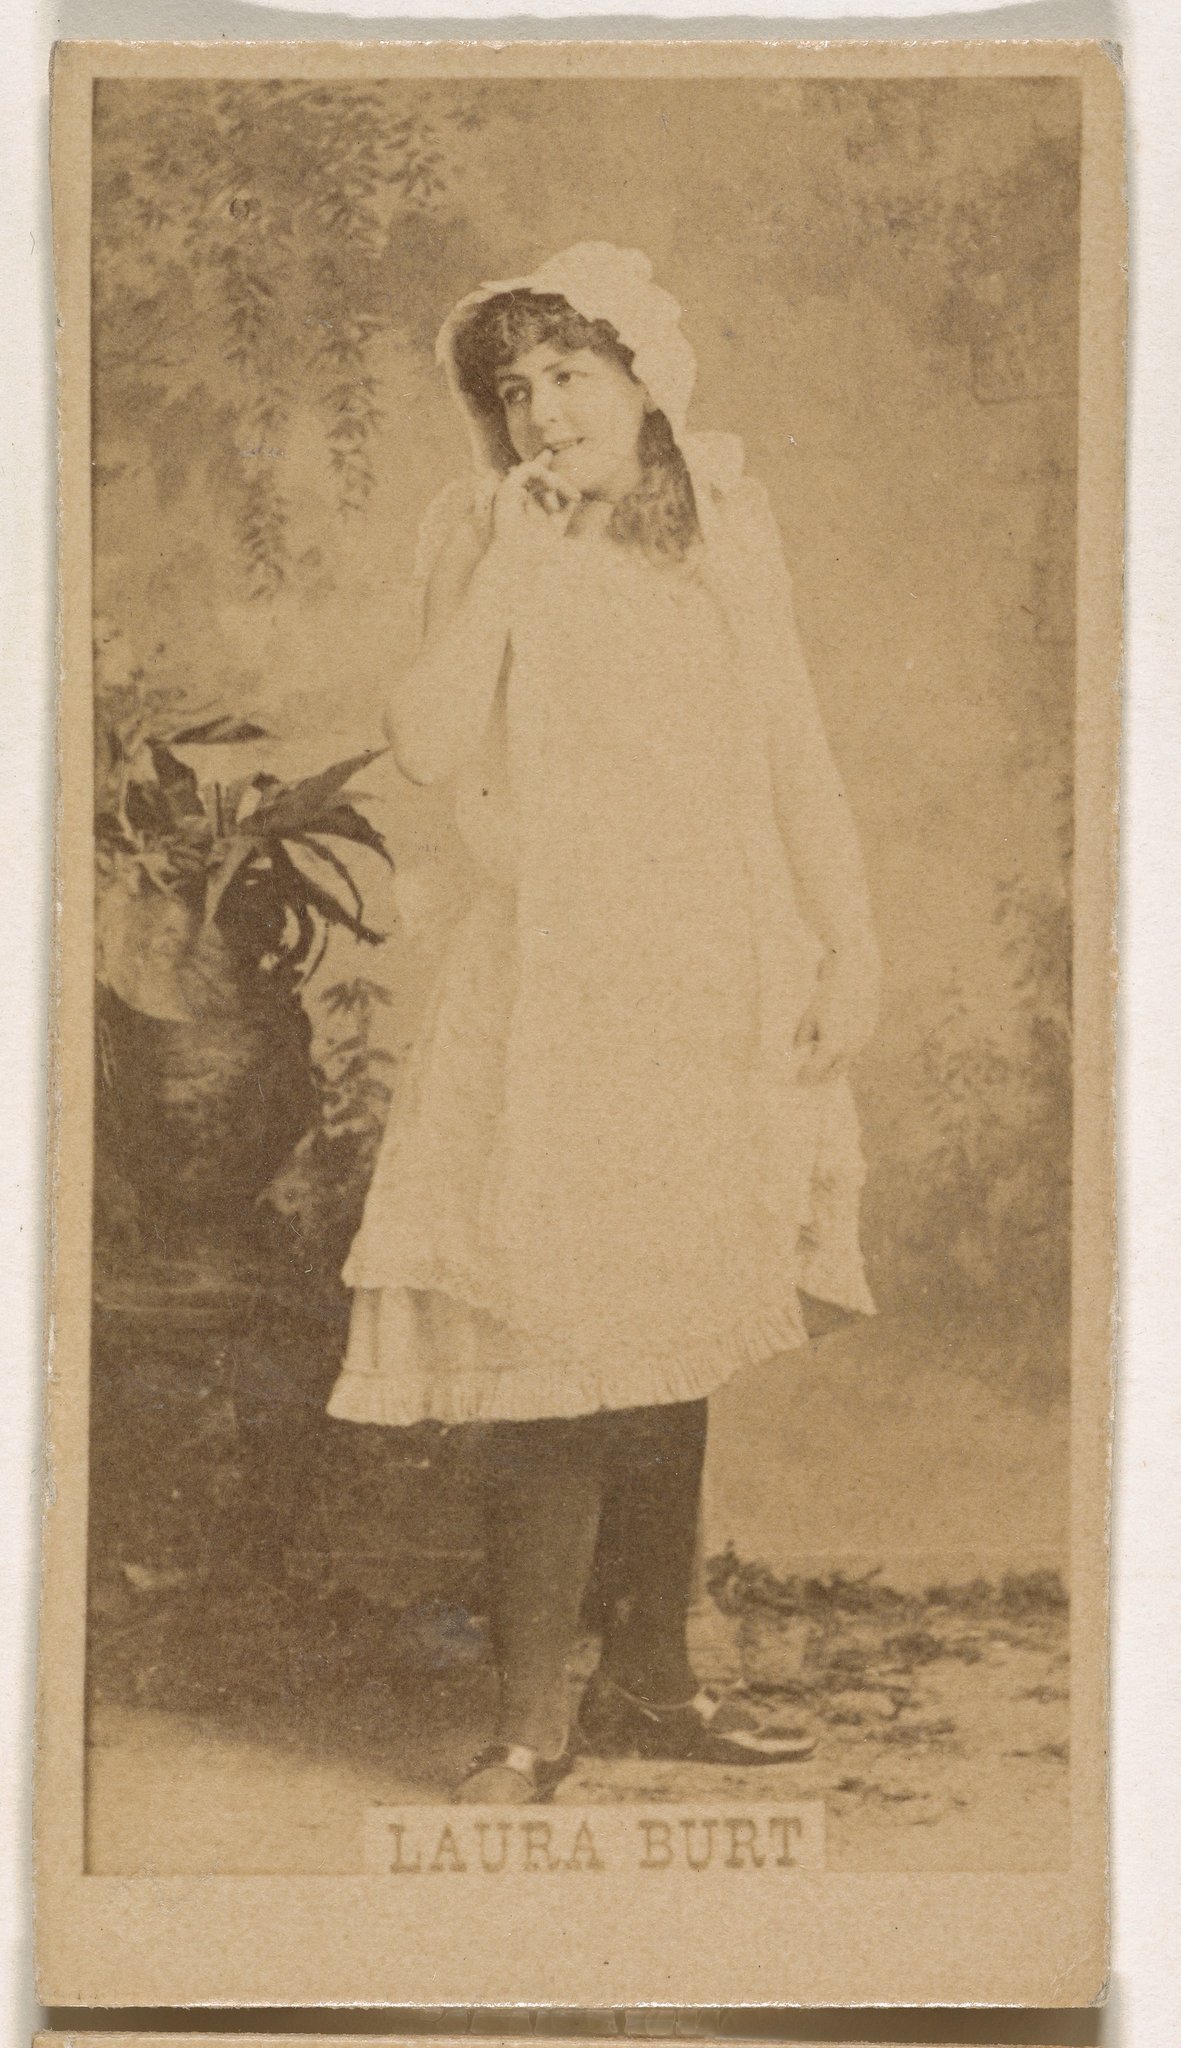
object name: photograph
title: Laura Burt, from the Actresses series (N245) issued by Kinney Brothers to promote Sweet Caporal Cigarettes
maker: kinney brothers tobacco company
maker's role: publisher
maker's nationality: american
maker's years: 1869-2011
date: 1890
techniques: albumen silver print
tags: portraits,women,actresses